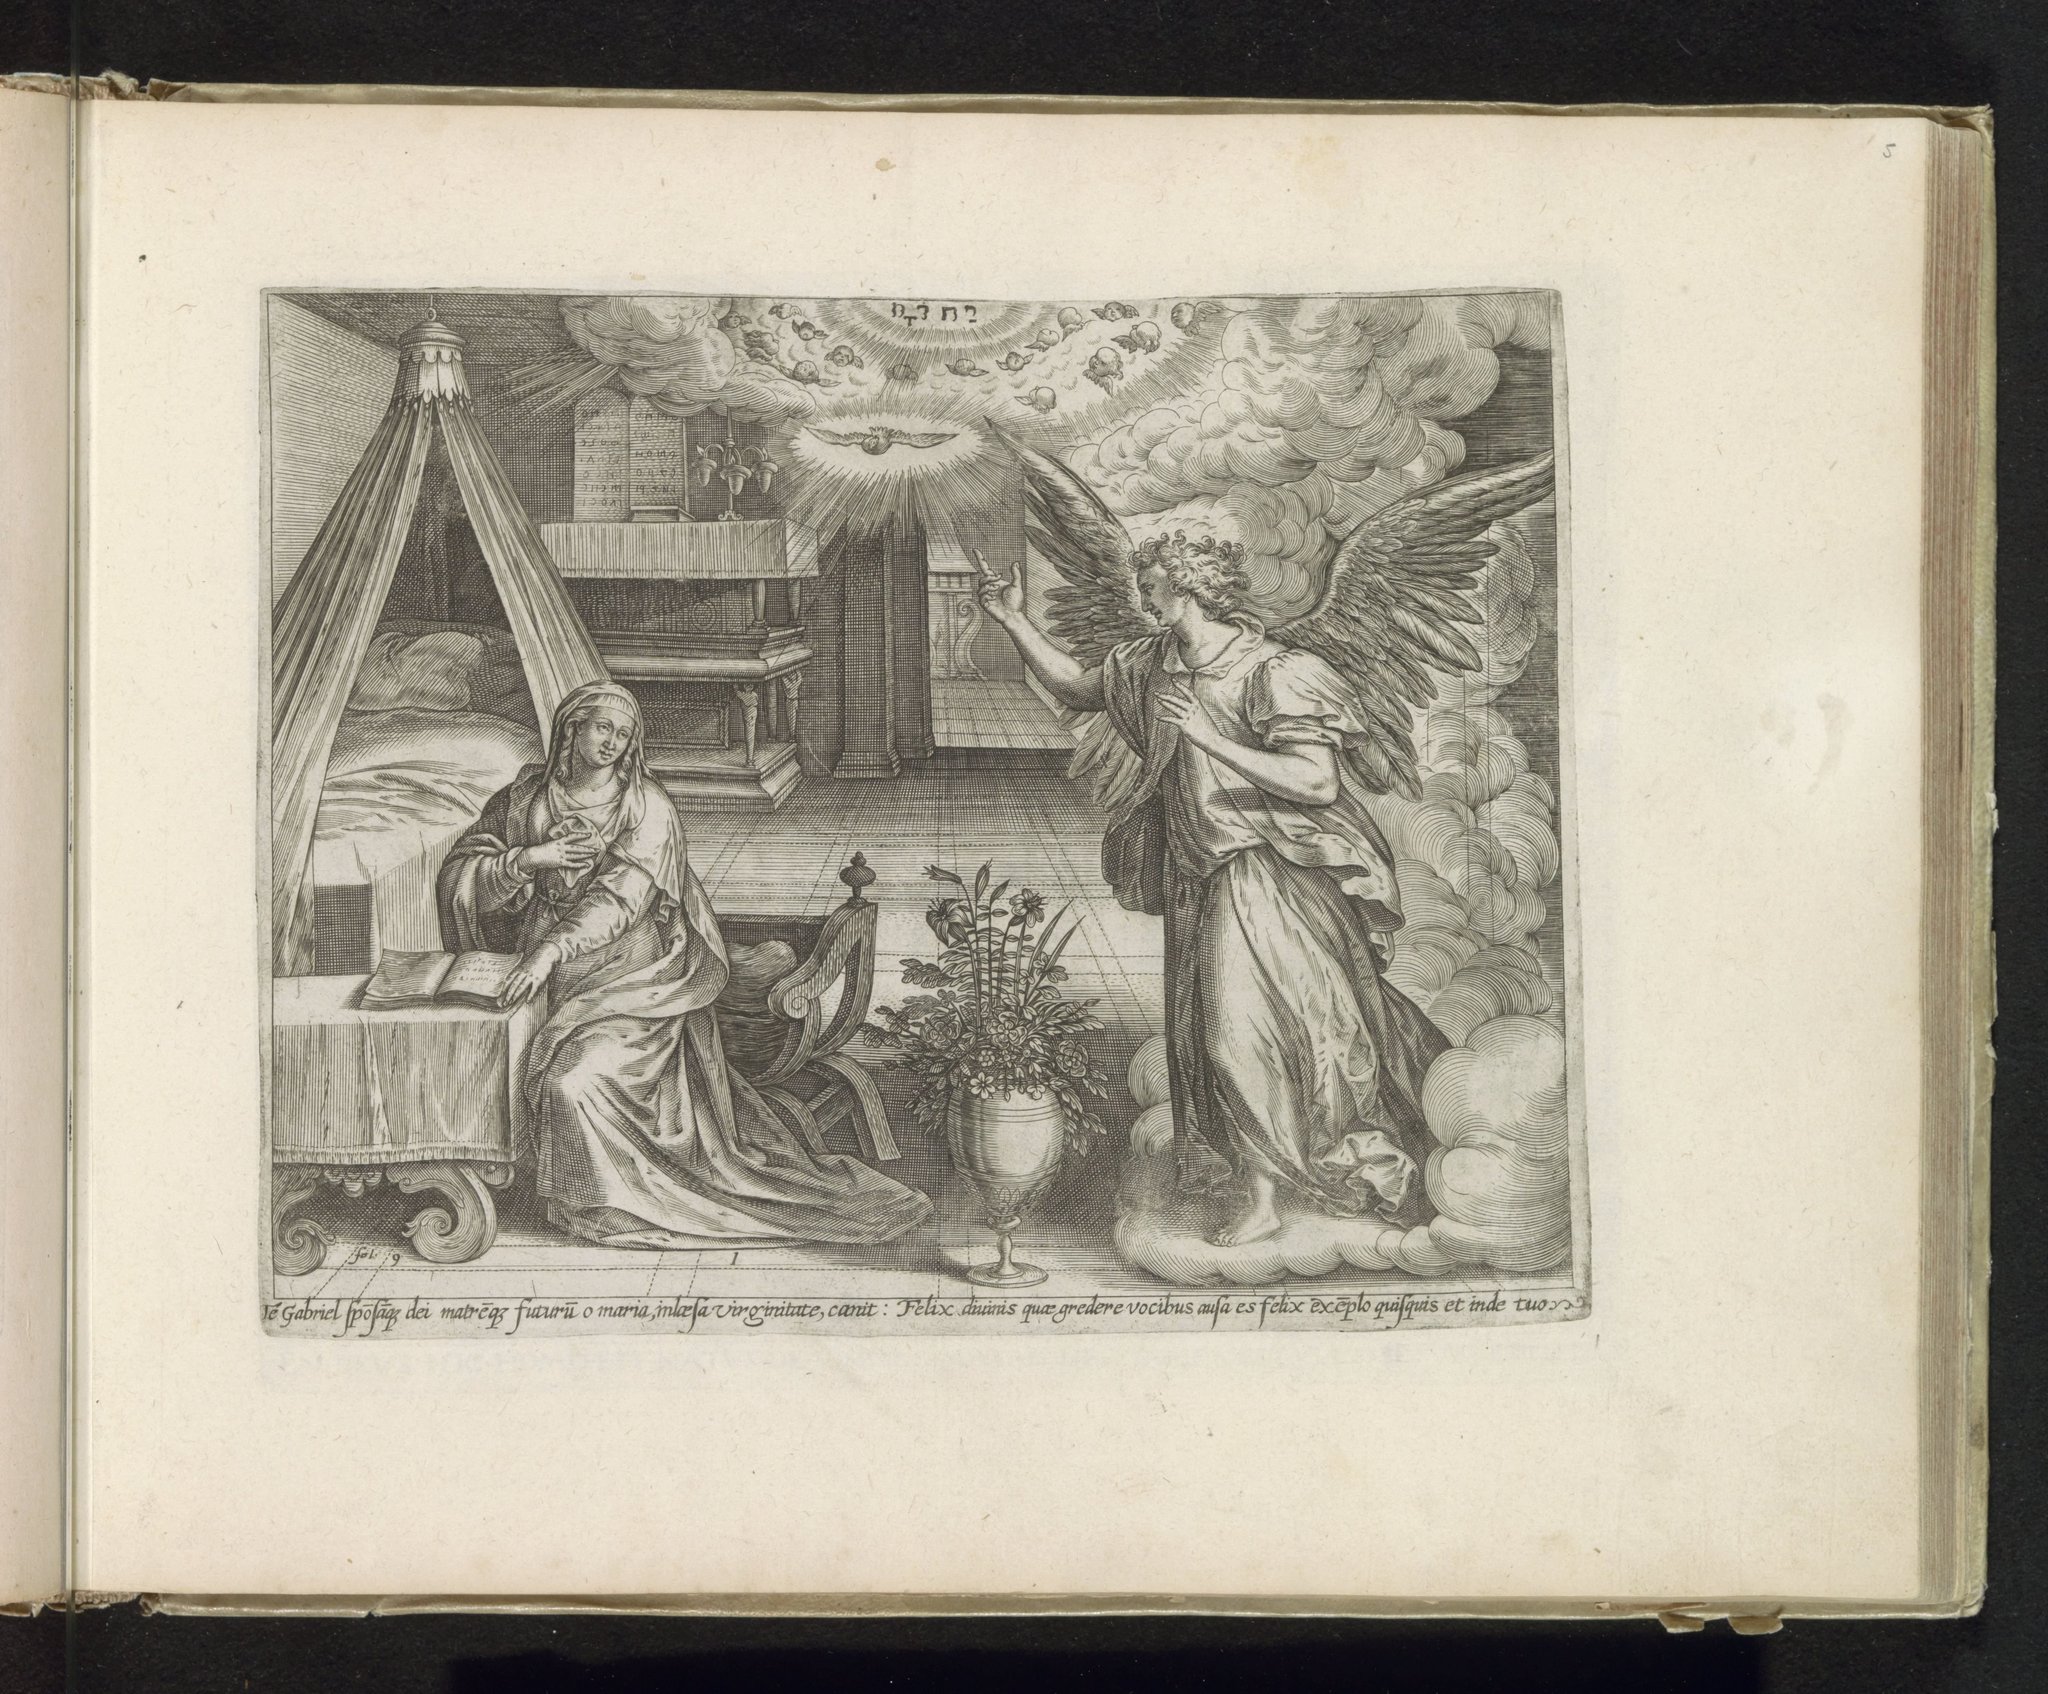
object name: album leaf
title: Thesaurus novi Testamenti elegantissimis iconibus expressus continens historias atque miracula doni nostri Iesu Christi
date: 1585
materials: paper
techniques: engraving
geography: antwerp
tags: the annunciation: mary sitting - aa - mary to the left, the angel to the right, tetragram (in roman or hebrew script) ~ symbol of god the father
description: De engel Gabriël kondigt aan Maria aan dat ze zwanger zal worden. Maria zit bij een tafel, waarop een opengeslagen boek ligt. Links een bed. De Heilige Geest daalt als een duif neer. Daarboven het tetragram als symbool van God de Vader en cherubijnen. Onder de voorstelling een verwijzing in het Latijn naar de Bijbeltekst in Luc. 1. Deze prent maakt deel uit van een album.